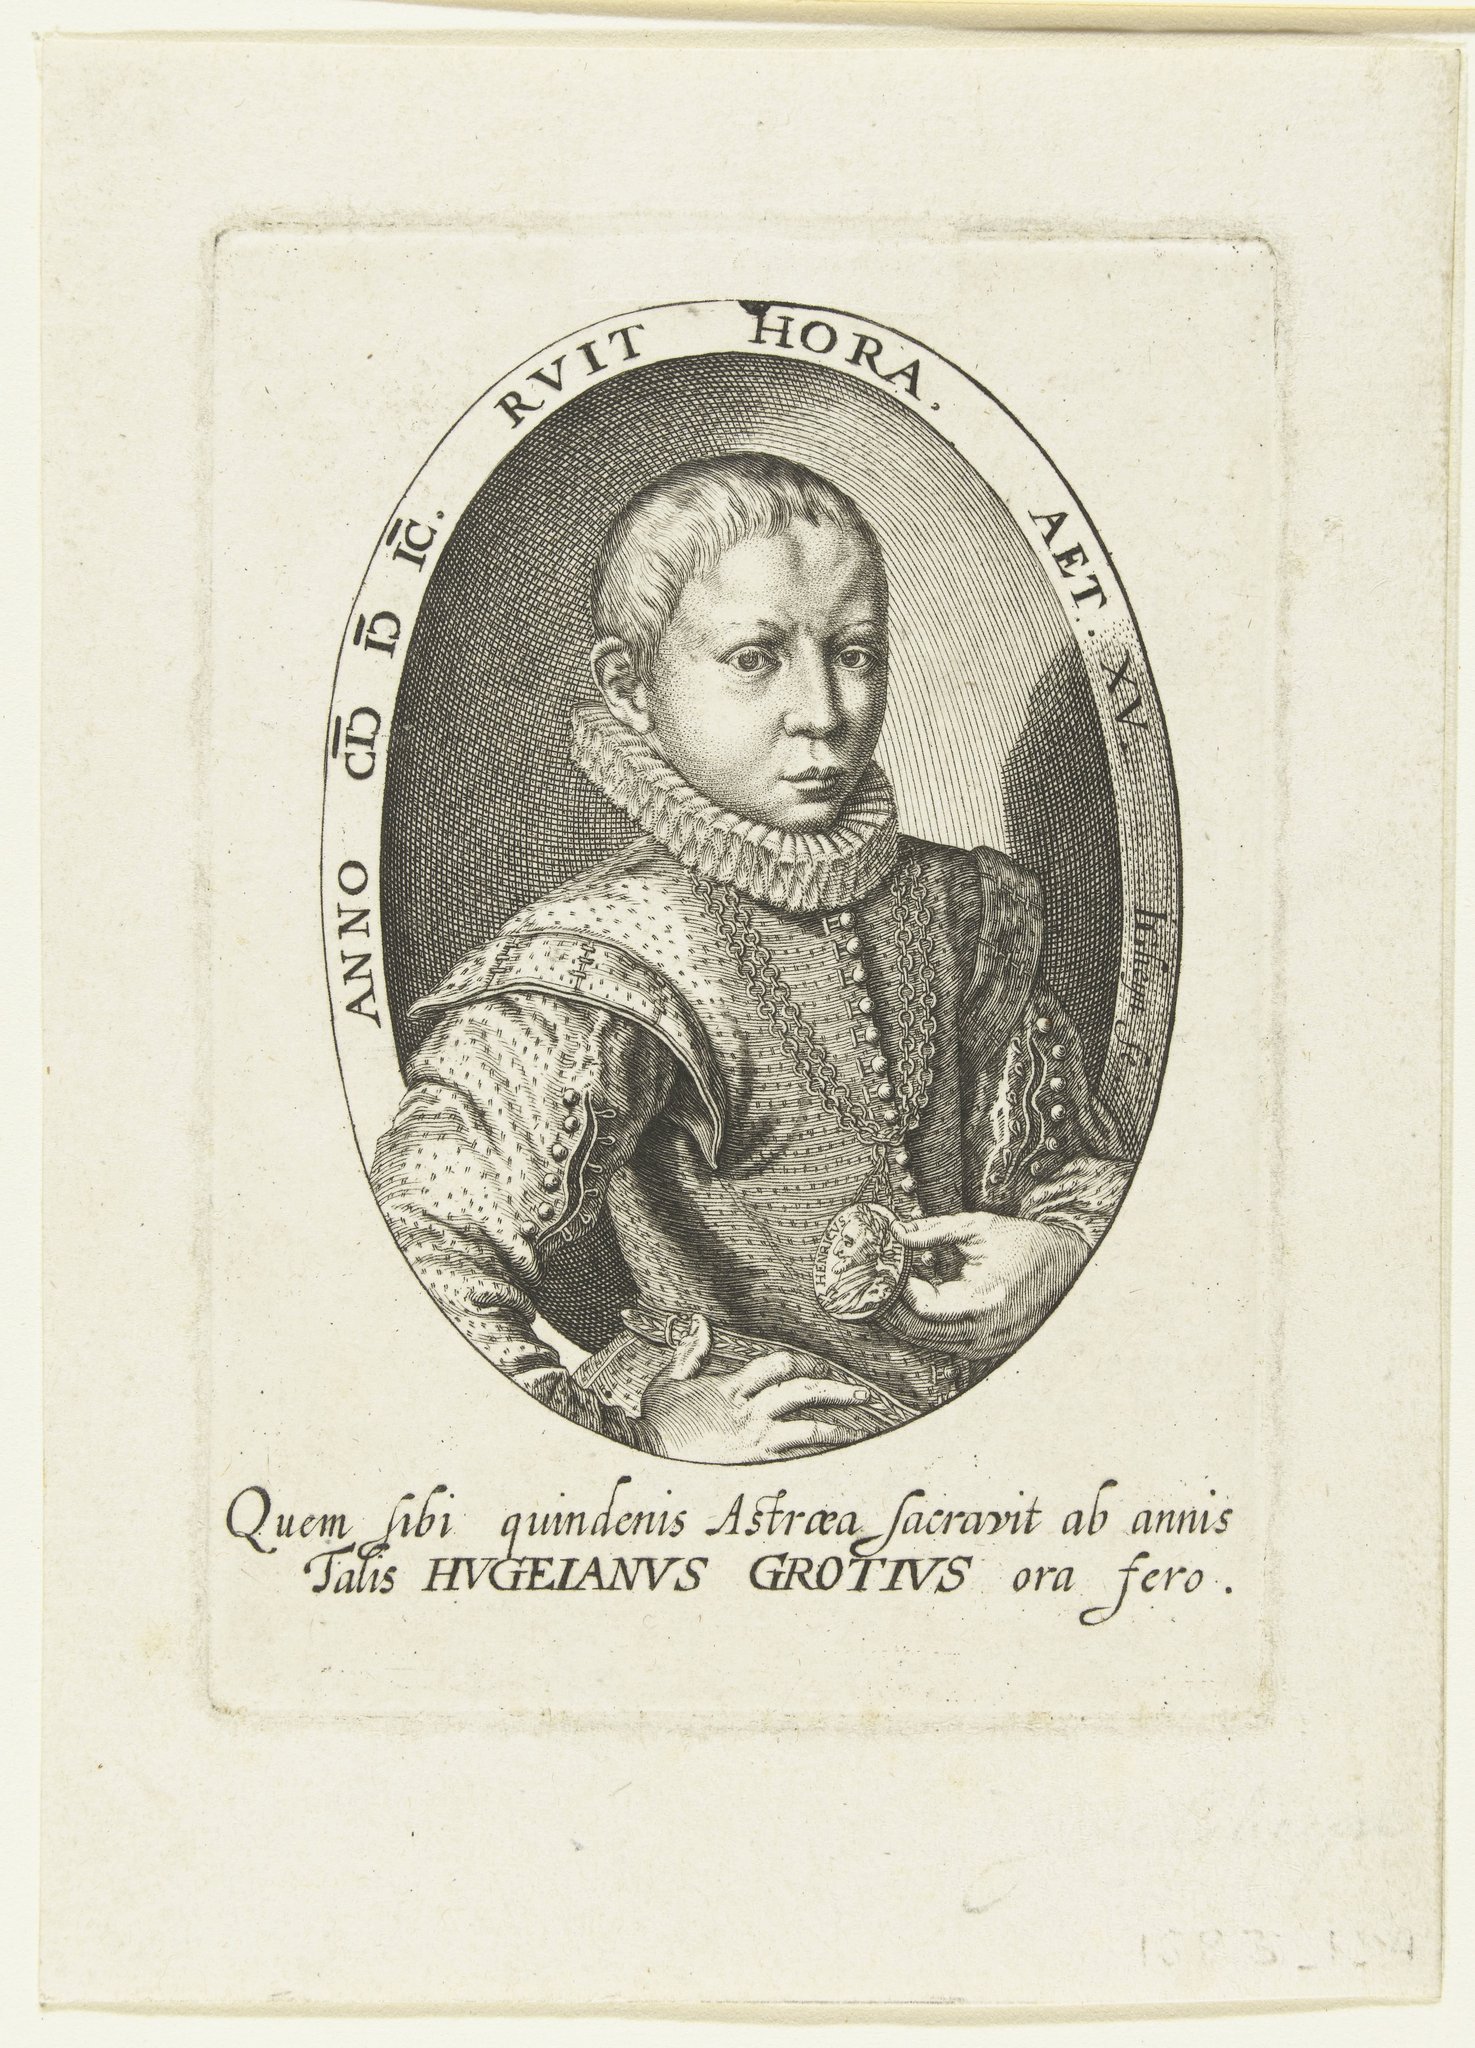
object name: print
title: Portret van Hugo de Groot op 15-jarige leeftijd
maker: jacques de gheyn (ii)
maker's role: painter, print maker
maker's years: 1565-1629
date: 1599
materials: paper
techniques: engraving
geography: netherlands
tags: delft, hugo de groot, aspects of science in general (+ child as scholar or scientist), neck-gear ~ clothing (ruff) (+ boys' clothes), sleeves (+ boys' clothes), clothing for the upper part of the body (doublet) (+ boys' clothes), historical persons, professor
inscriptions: collector's mark: Lugt 964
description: Buste van Hugo de Groot als 15-jarige jongeman, min of meer op de rechterzijde gezien, in ovaal. Het wonderkind Hugo de Groot had in 1599 (datering prent) al een universitaire studie achter de rug: tijdens zijn verblijf in Frankrijk in 1598 was hij in de rechten gepromoveerd. Koning Hendrik IV schonk hem bij deze gelegenheid een medaillon, dat hij hier in de linkerhand houdt. Om de voorstelling een regel Latijnse tekst, onder de voorstelling twee regels Latijnse tekst.